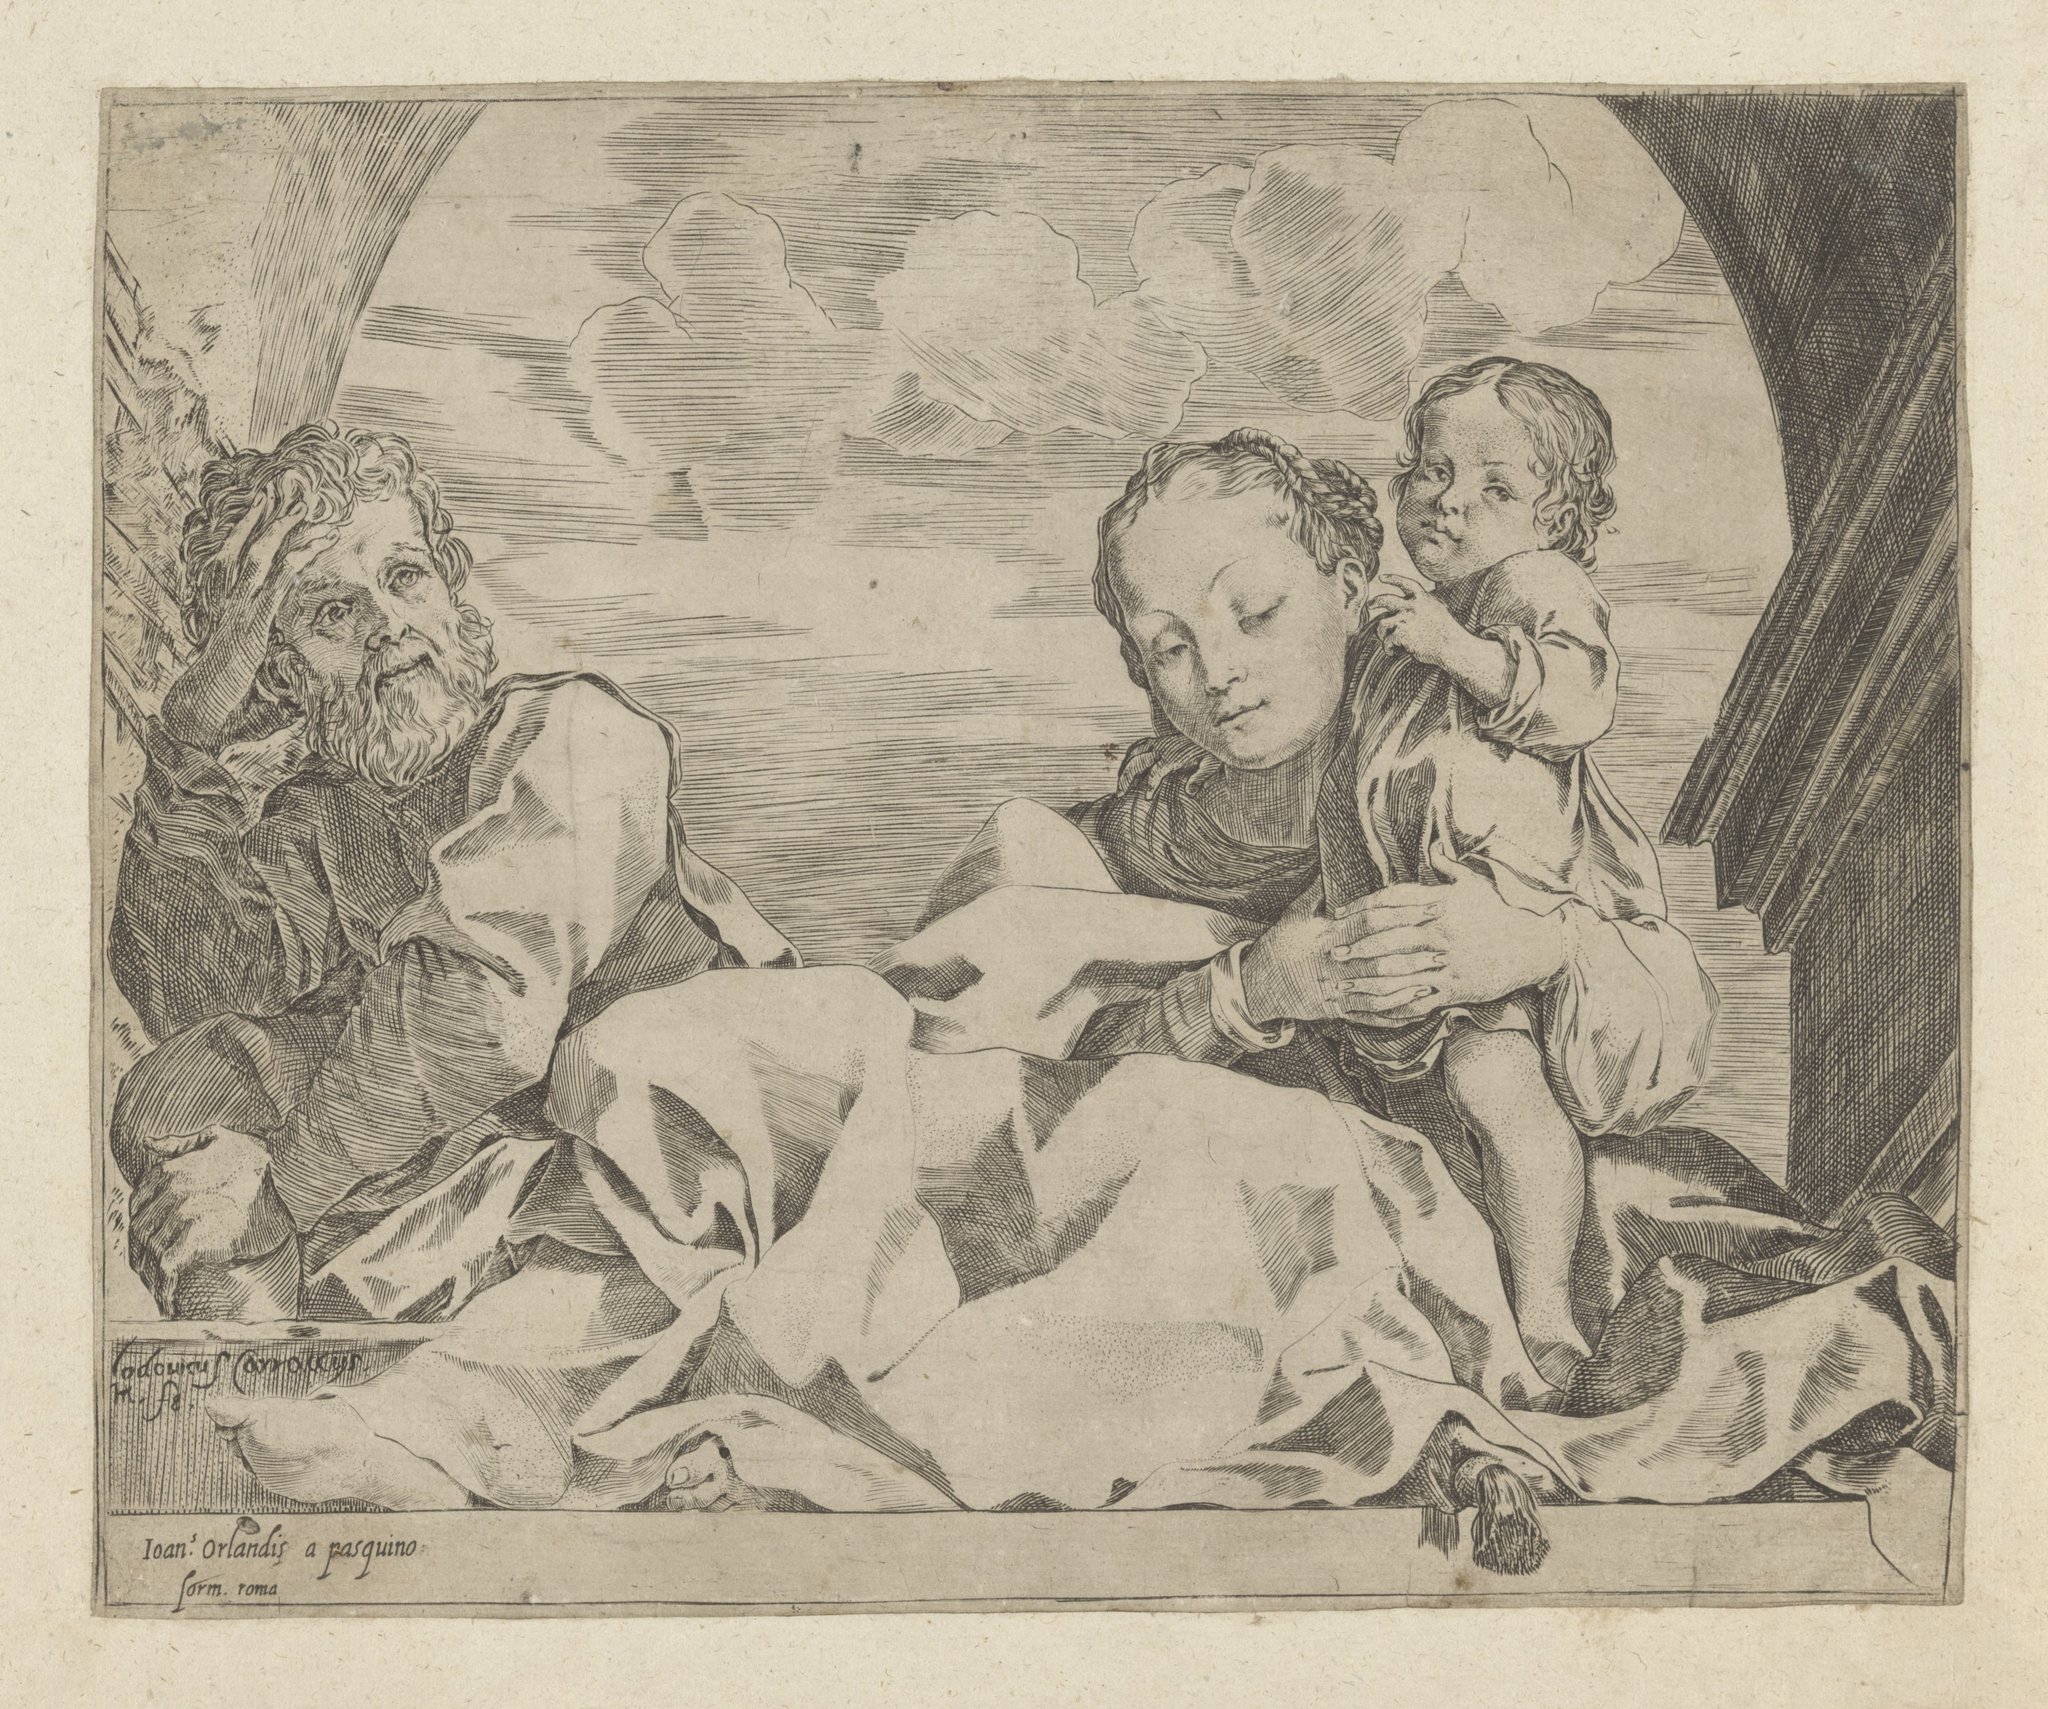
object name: print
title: Heilige Familie onder een boog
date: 1585-1590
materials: paper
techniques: engraving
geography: italy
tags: holy family, and derived representations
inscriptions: collector's mark: Lugt 240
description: Een getekende voorstudie voor de figuur van Jozef wordt bewaard in het Ashmolean Museum in Oxford. Een voorstudie voor de figuren van Maria en Christus wordt bewaard in de collectie van John Winter te Londen.